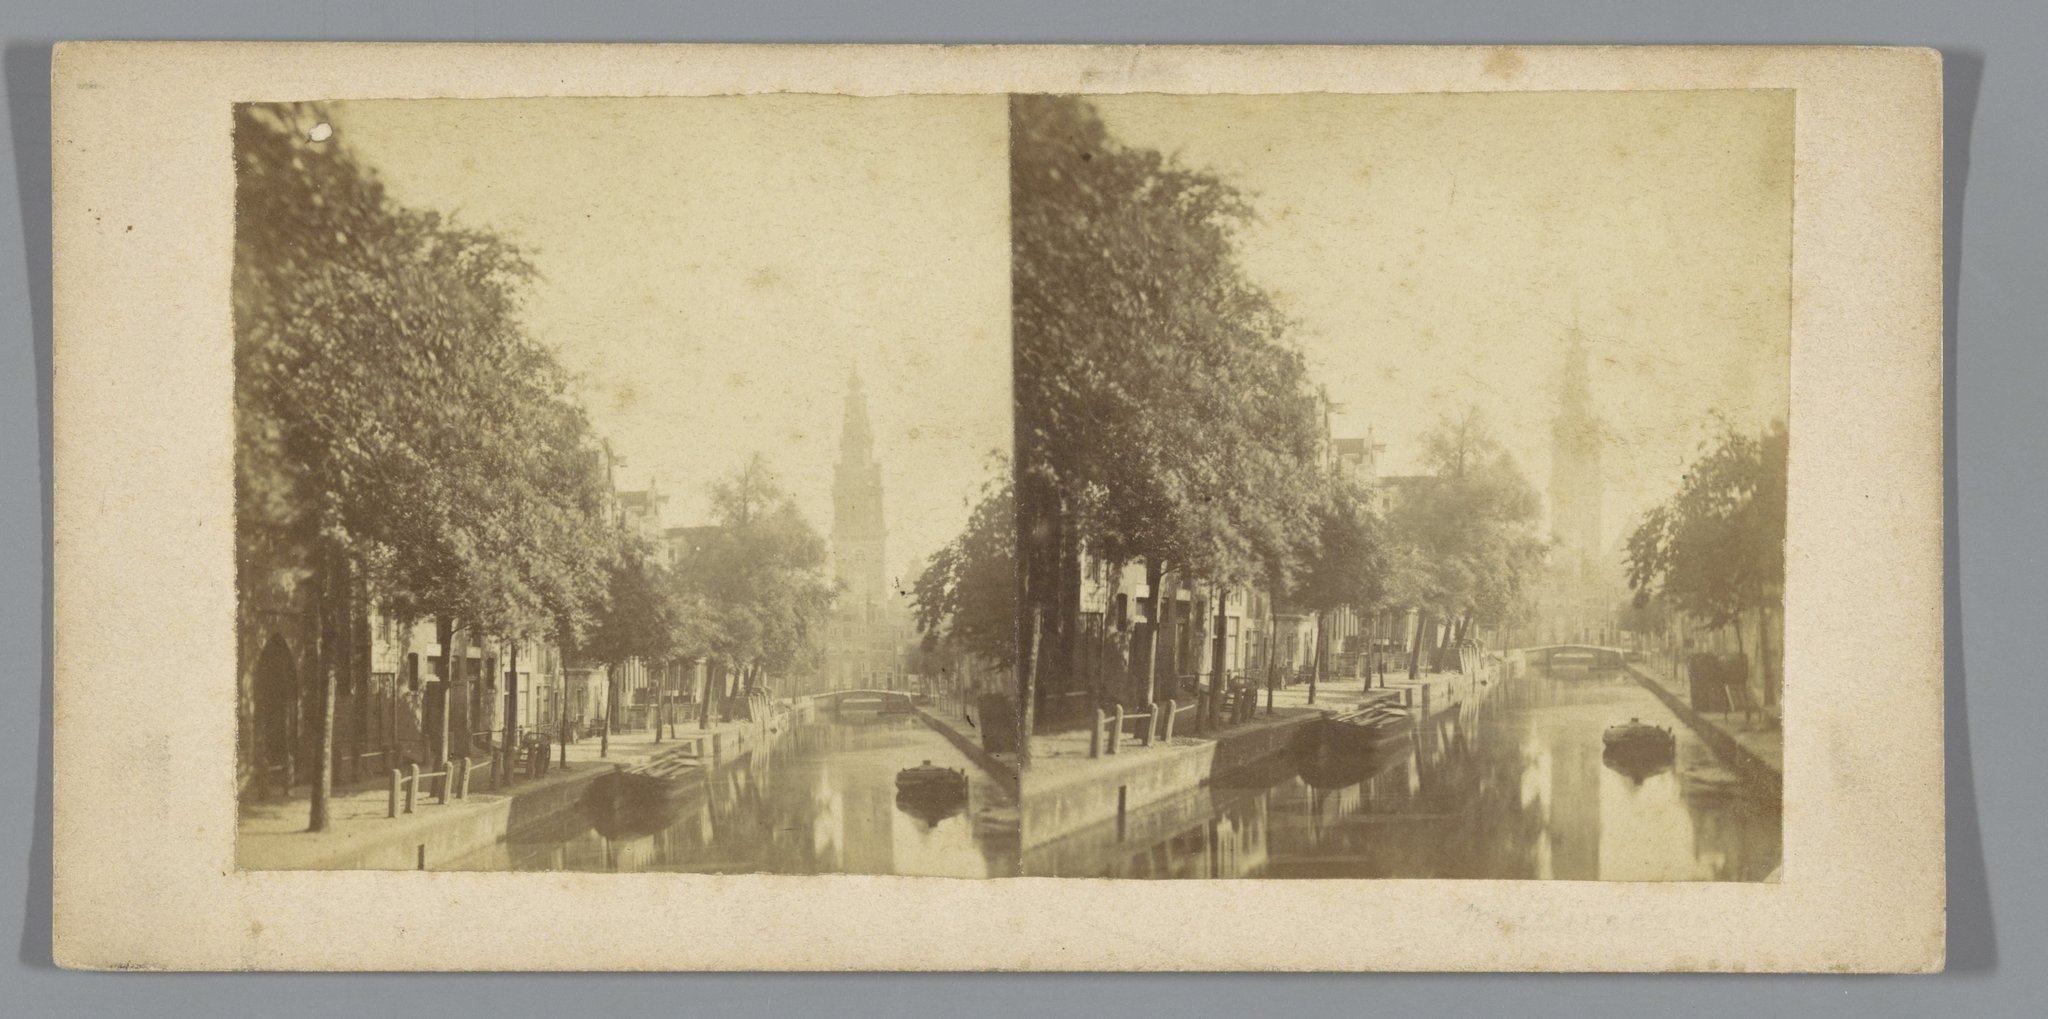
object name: stereograph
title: Groenburgwal met de Zuiderkerk, Amsterdam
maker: Anonymous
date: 1857-1863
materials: cardboard, paper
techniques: albumen print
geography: amsterdam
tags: canals, waters (in city)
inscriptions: inscription: ‘75Ct’, inscription: ‘Groenburgwal, Z.Kerk’